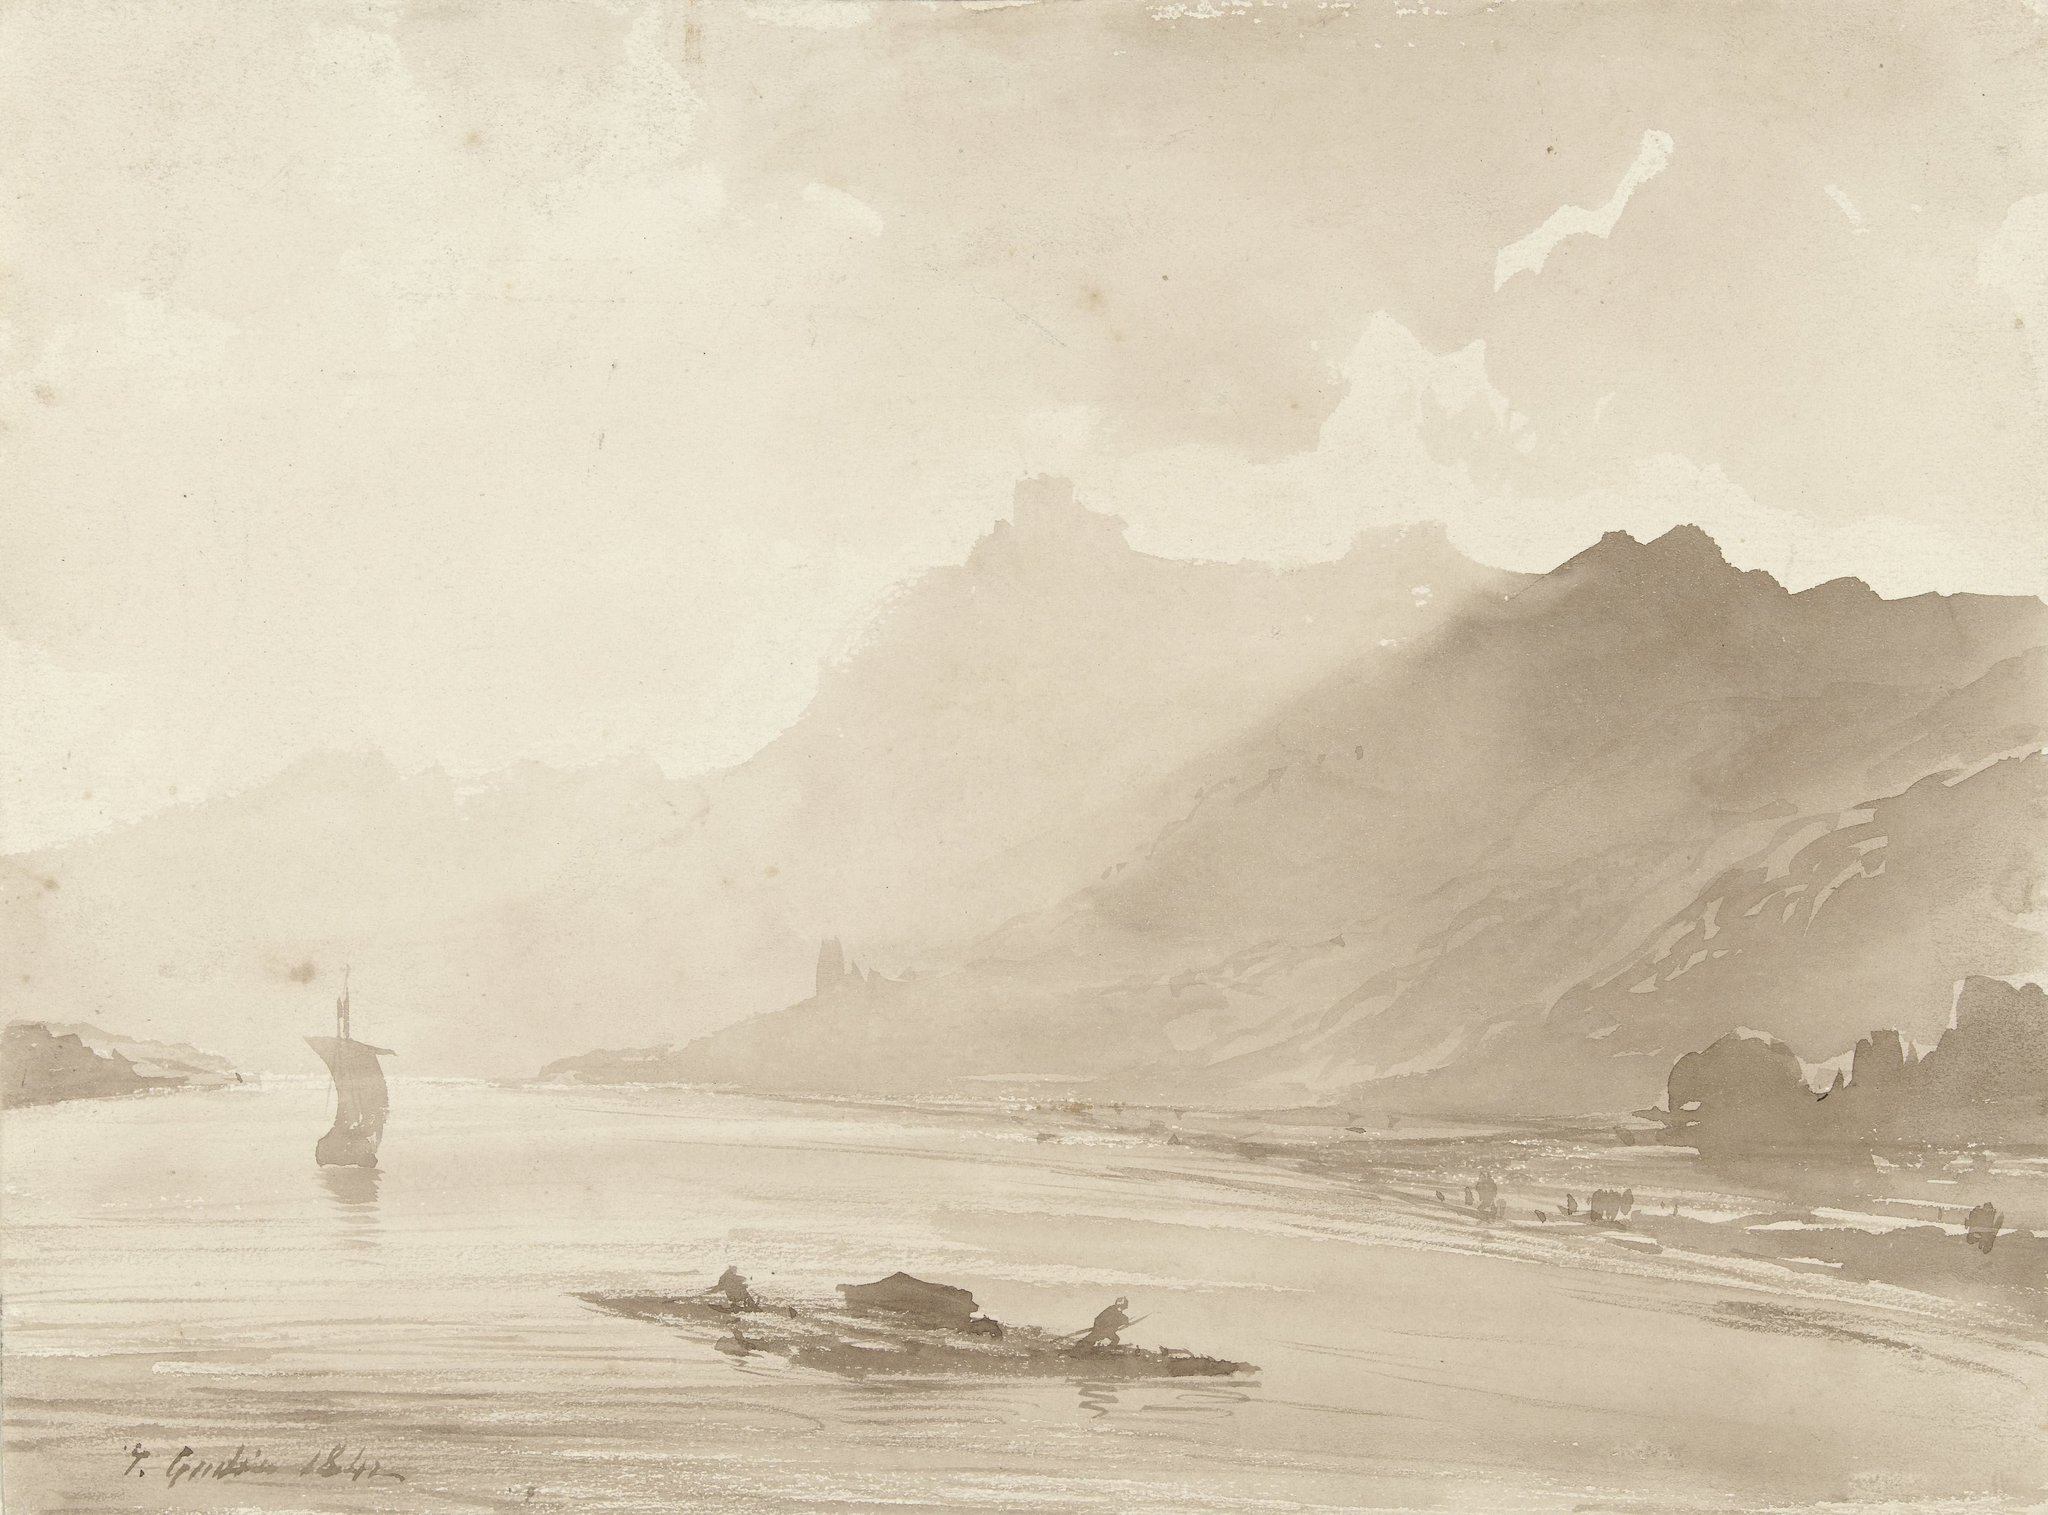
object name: drawing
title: Gezicht aan de Rijn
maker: théodore gudin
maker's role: draughtsman, painter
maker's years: 1802-1880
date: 1842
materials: paper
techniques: brush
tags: river (+ landscape with figures, staffage)